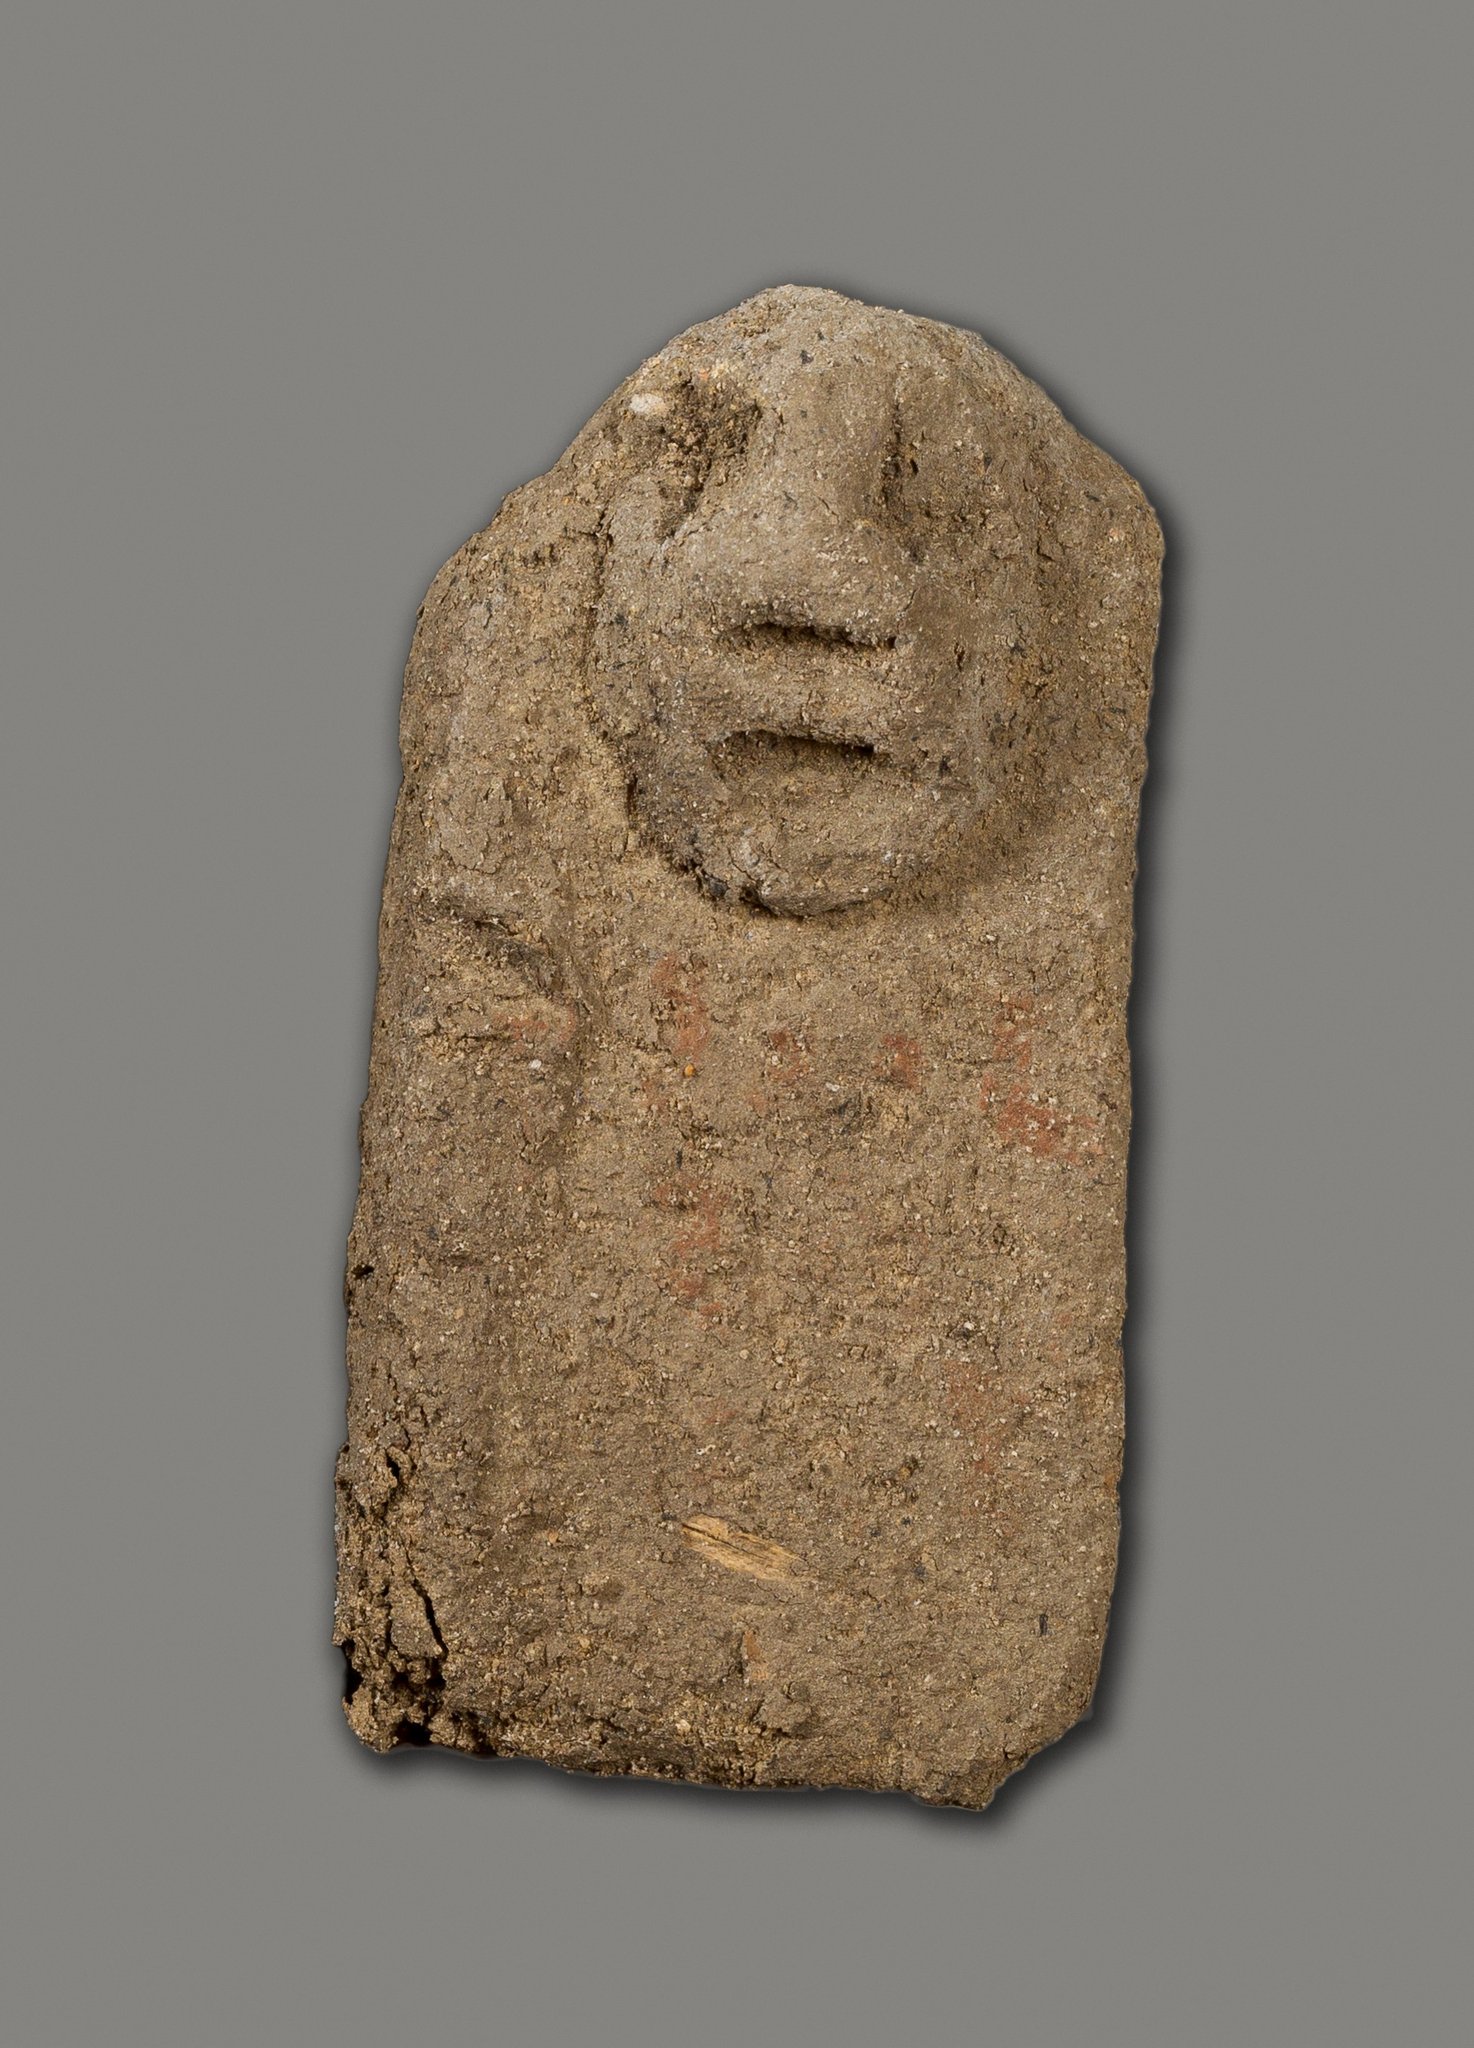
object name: figure, magical, execration, tablet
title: Magical Figure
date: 1802-1550 BCE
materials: clay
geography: egypt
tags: faces